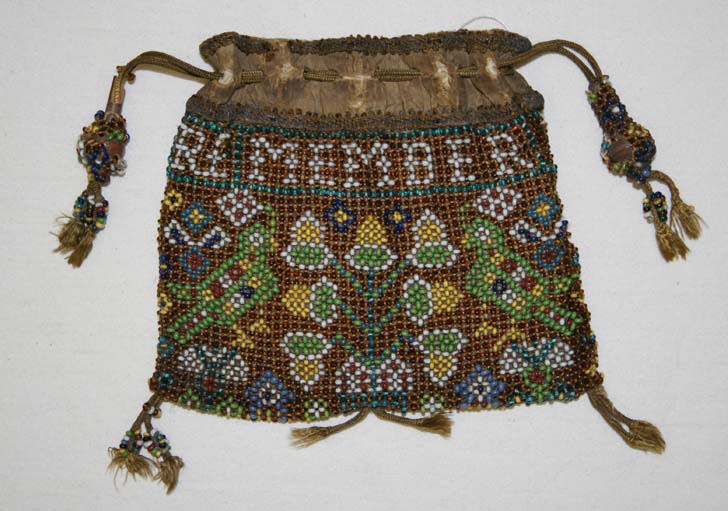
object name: drawstring bag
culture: british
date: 1630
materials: glass, leather, silk, wood